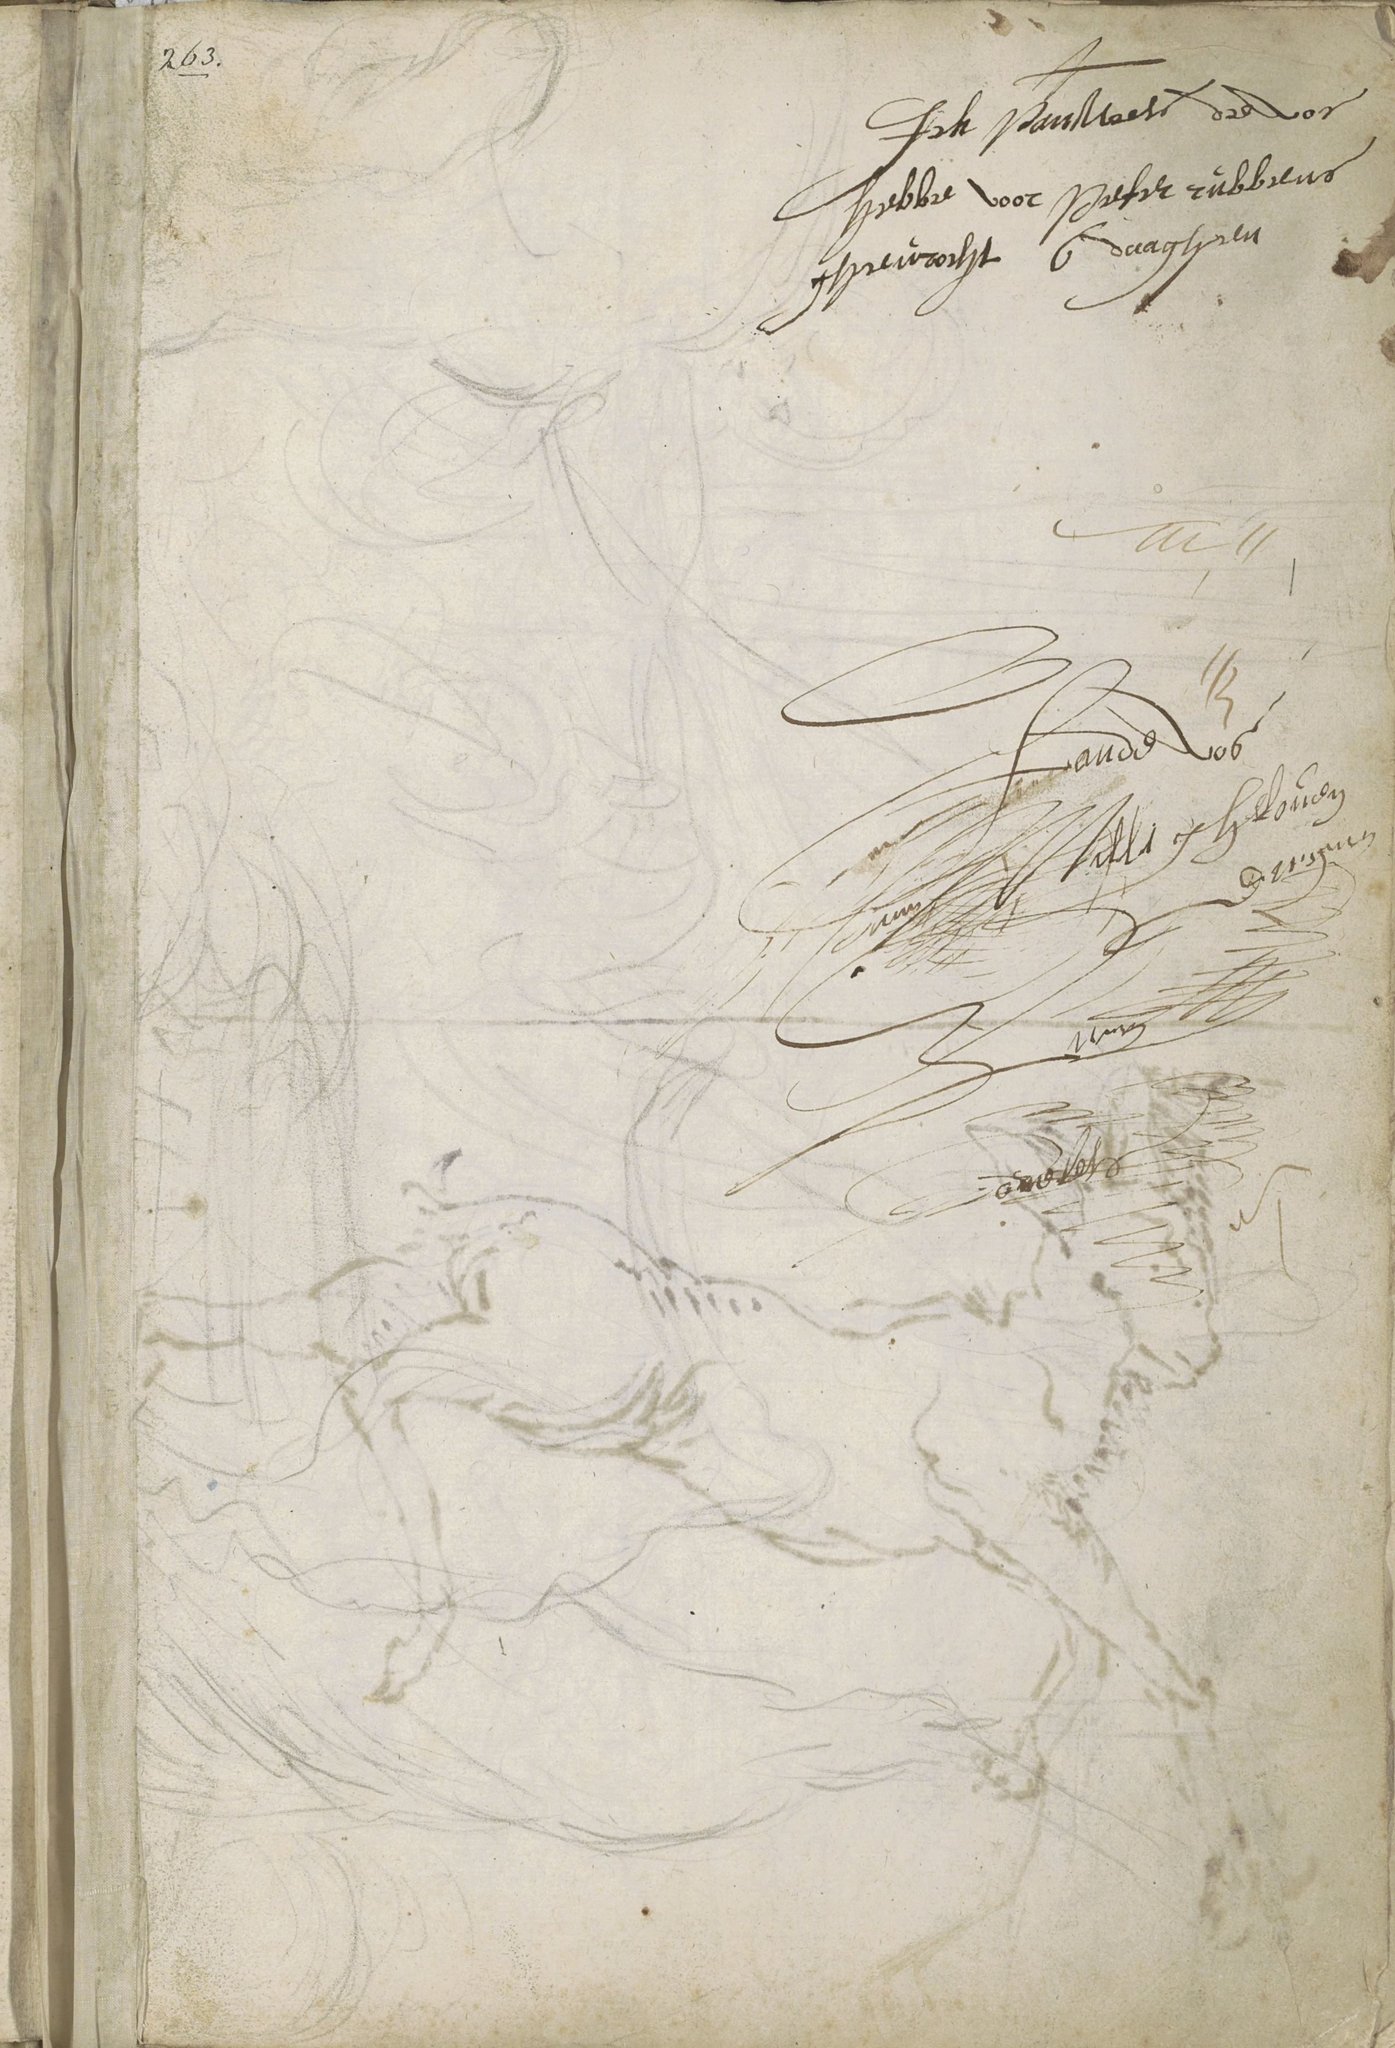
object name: sketchbook leaf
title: Studies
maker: paul de vos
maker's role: draughtsman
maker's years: 1595-1678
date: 1605-1678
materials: paper, pencil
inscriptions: annotation: ‘Ick Pauw[...]els de Vos/ hebbe voor Pieter rubbens/ gewrocht 6 daaghen/ [...]’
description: Blad 1 recto uit een schetsboek met 15 bladen.